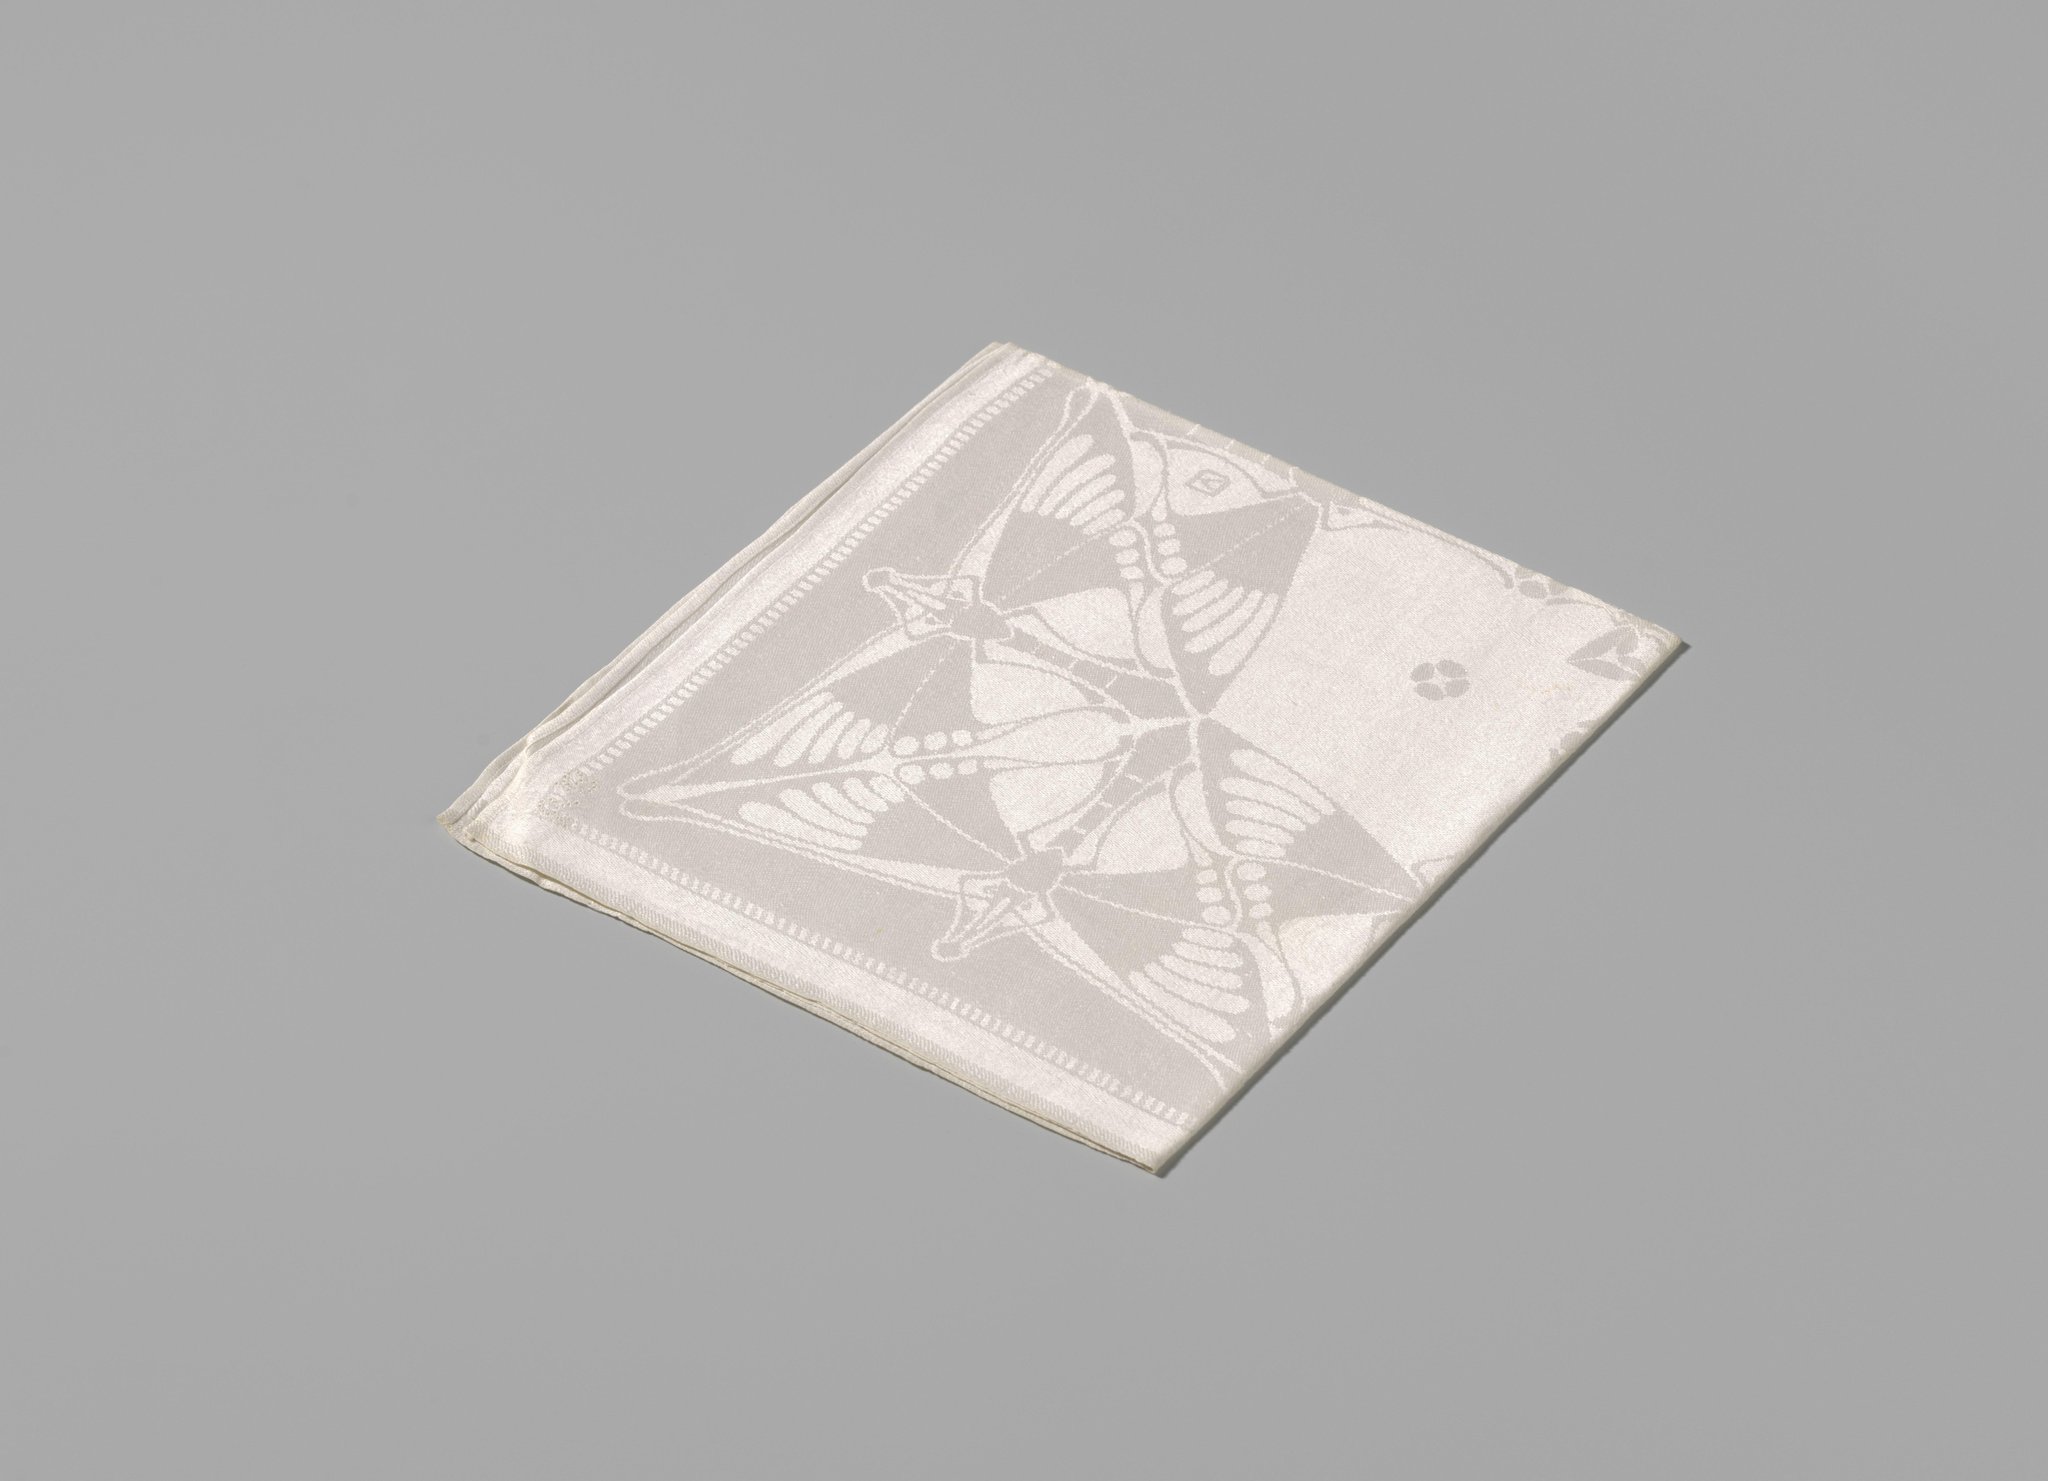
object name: vingerdoek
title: Vingerdoek van linnendamast met vlinders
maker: chris lebeau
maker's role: draughtsman, print maker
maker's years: 1878-1945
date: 1904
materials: linen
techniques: damask, weave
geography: eindhoven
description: Vingerdoek van linnendamast met vlinders: motief Vlinder, dessin nr. 505. De vingerdoek hoort bij elf vingerdoeken (BK-1979-260-A t/m BK-1979-260-L), dertien servetten (BK-1979-259-A t/m BK-1979-259-M) en twee tafellakens (BK-1979-258-A en BK-1979-258-B).